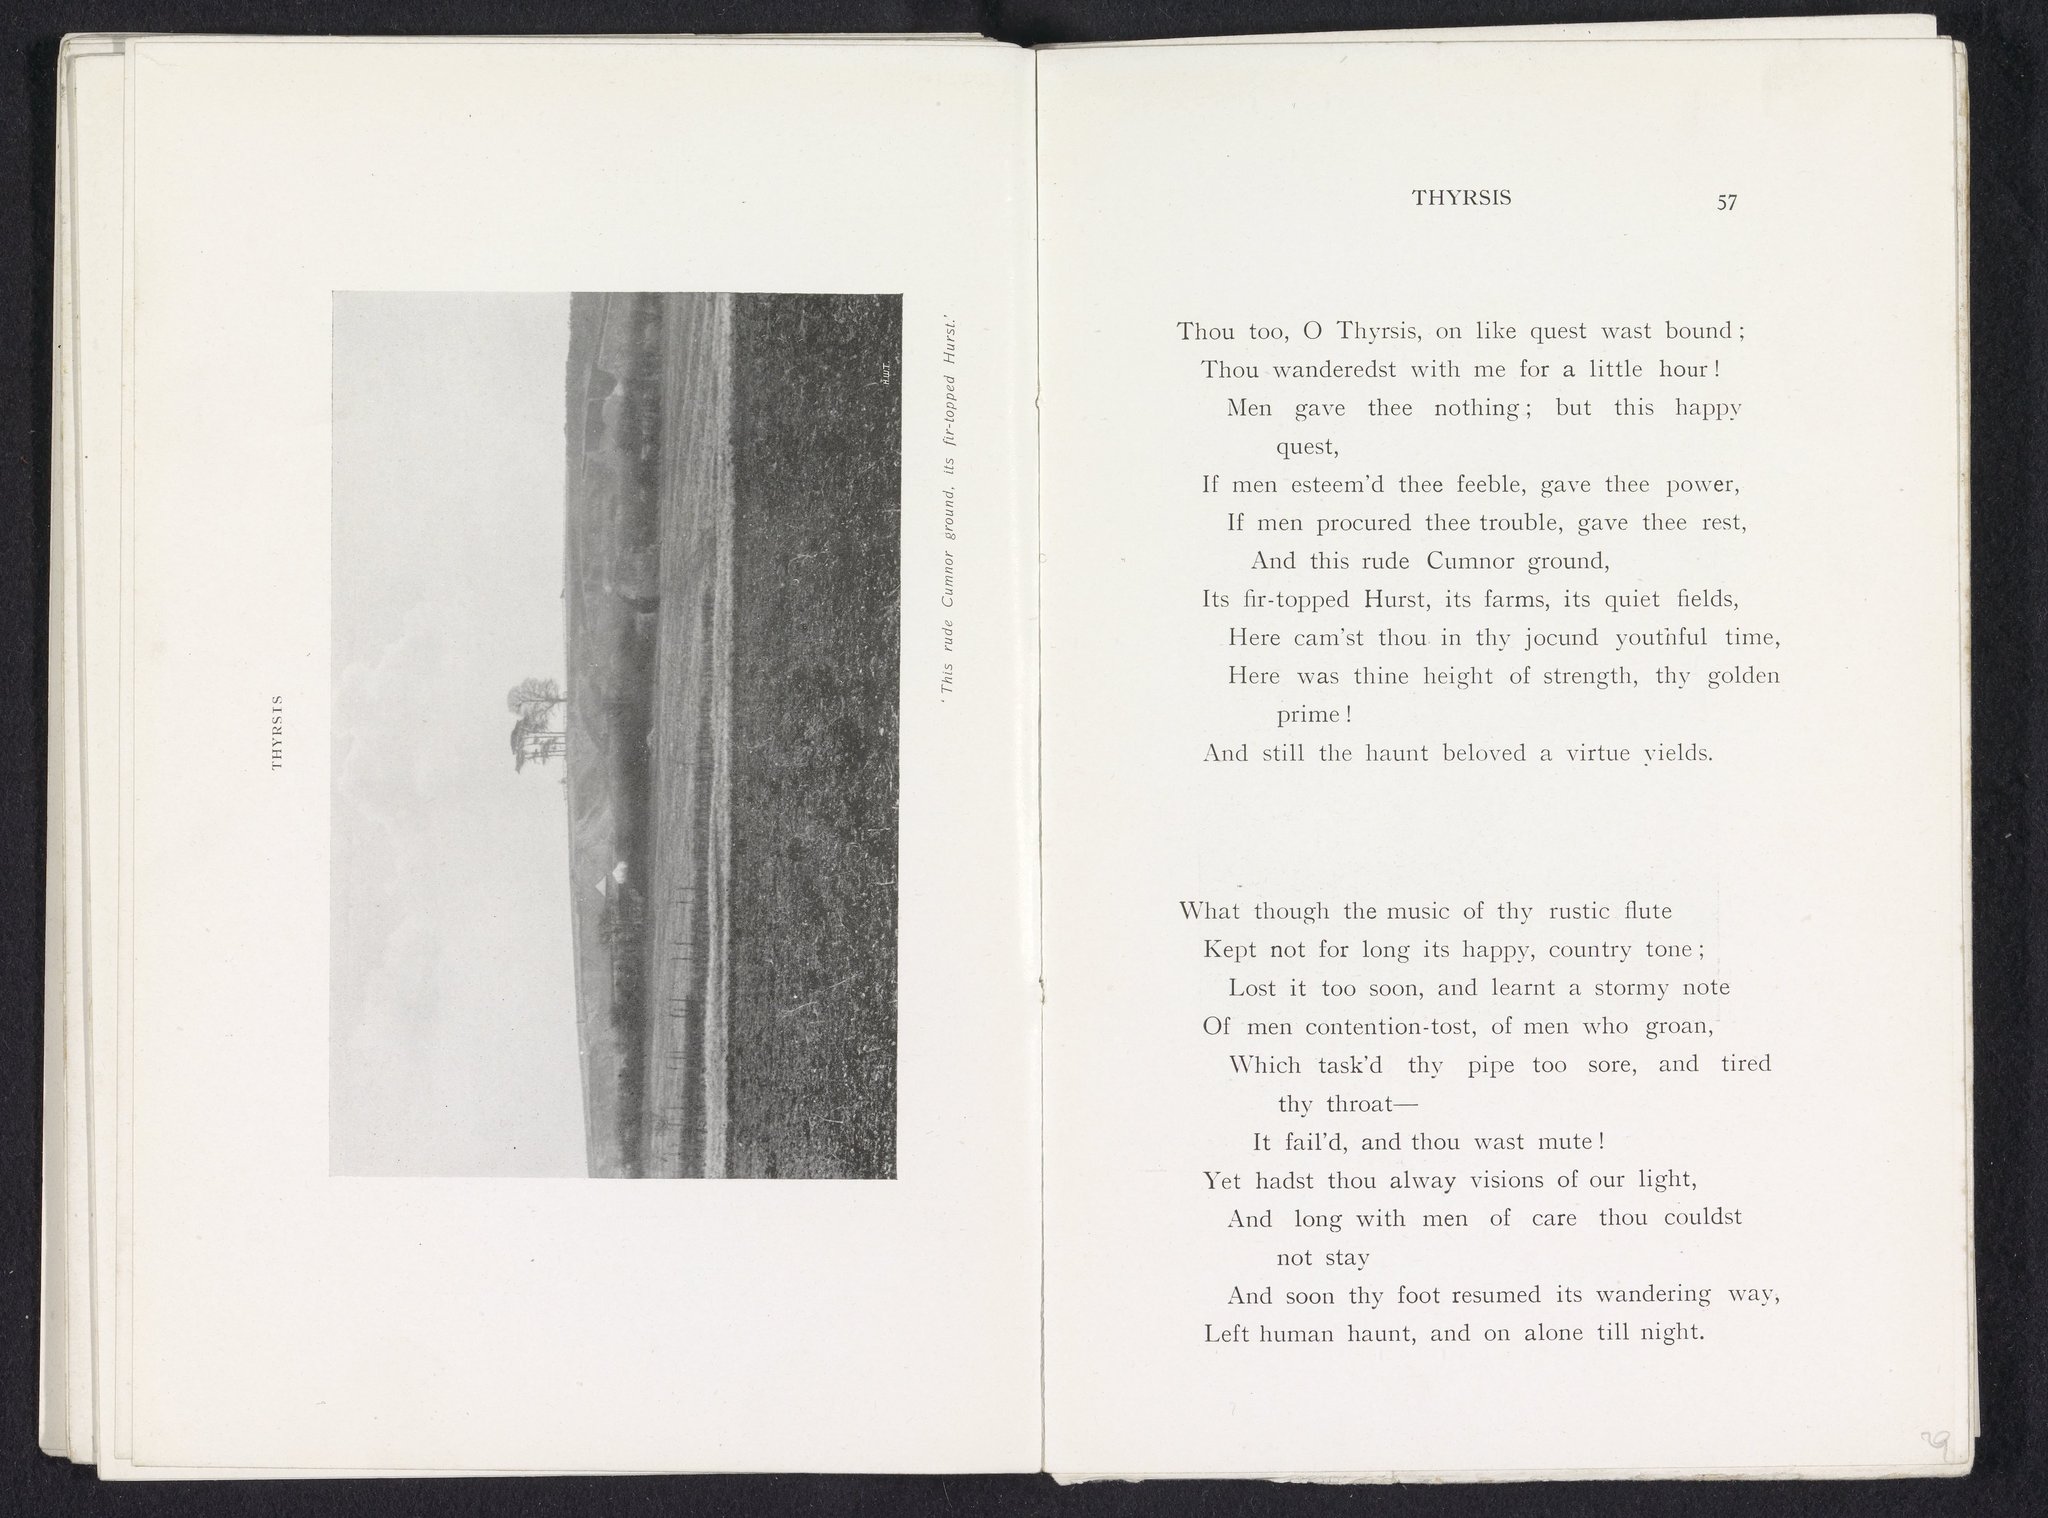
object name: page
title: Gezicht op een weidelandschap te Cumnor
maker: henry w. taunt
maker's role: fotograaf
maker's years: 1842-1922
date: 1907-1912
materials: paper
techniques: autotype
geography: cumnor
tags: meadow, pasture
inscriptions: inscription: ‘'This rude Cumnor ground, its fir-topped Hurst.'’